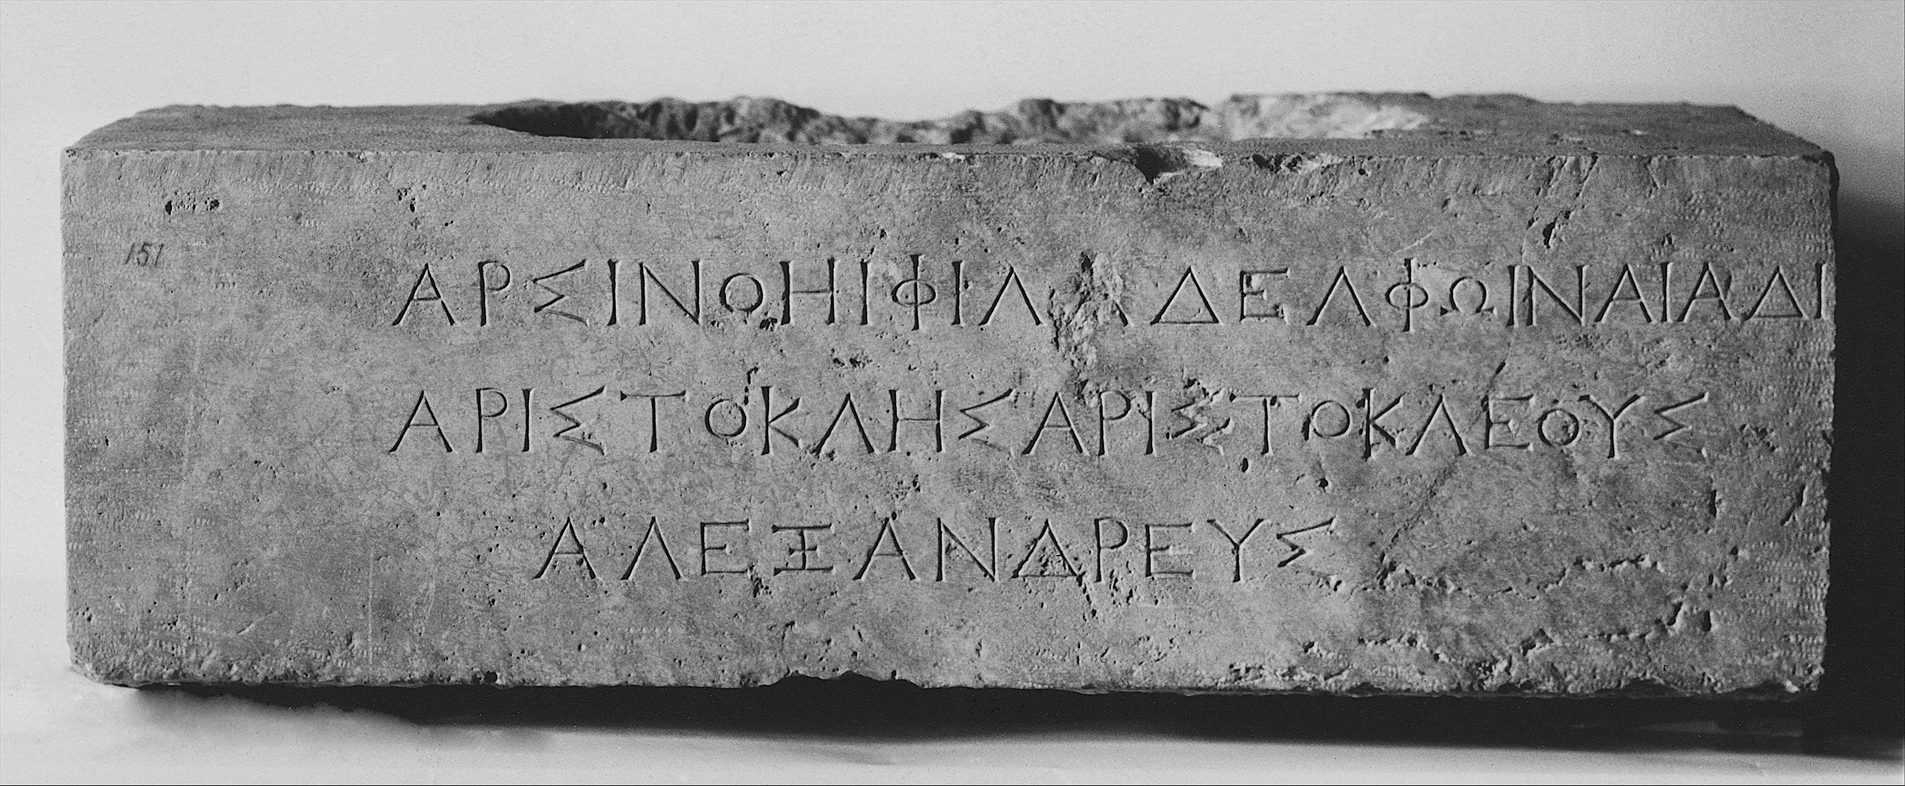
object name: statue base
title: Inscribed marble statue base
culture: greek, cypriot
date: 270-250 BCE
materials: marble